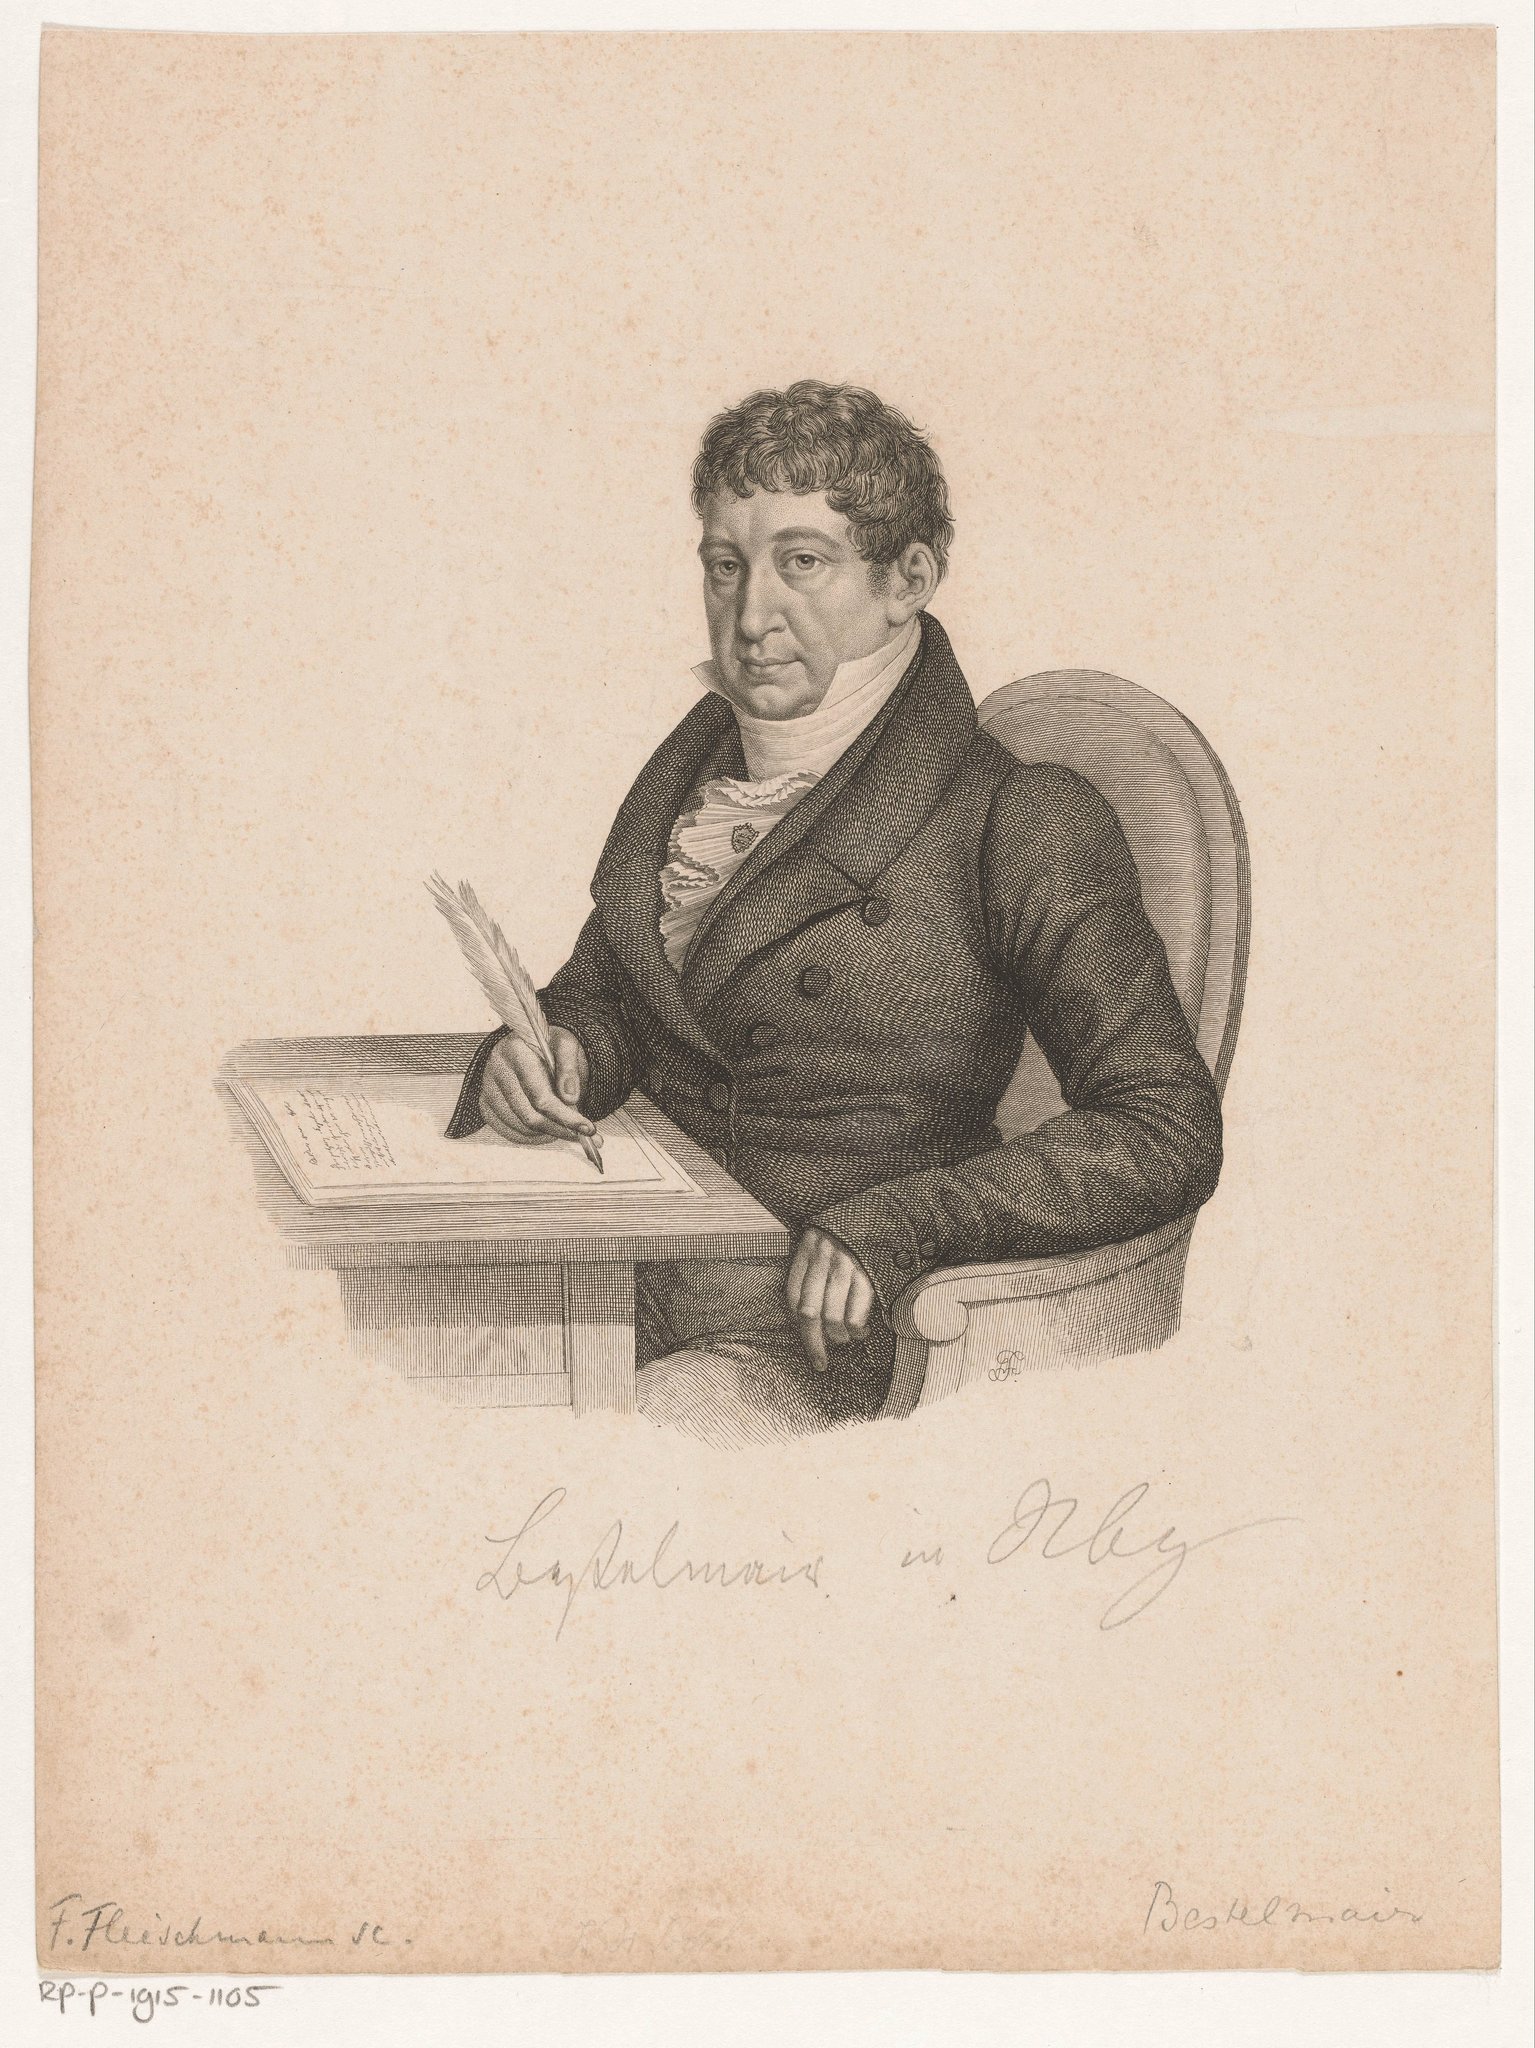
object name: print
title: Portret van een onbekende schrijvende man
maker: friedrich fleischmann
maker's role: print maker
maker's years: 1791-1834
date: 1801-1834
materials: paper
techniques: engraving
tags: historical persons, author, poet writing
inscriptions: collector's mark: Lugt 2228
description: In potlood is onder het portret 'Ley[...]almair in [...]by' geschreven. Het betreft hier mogelijk Georg H. Bestelmeier (GND: 121599566, HAB: A 1500).